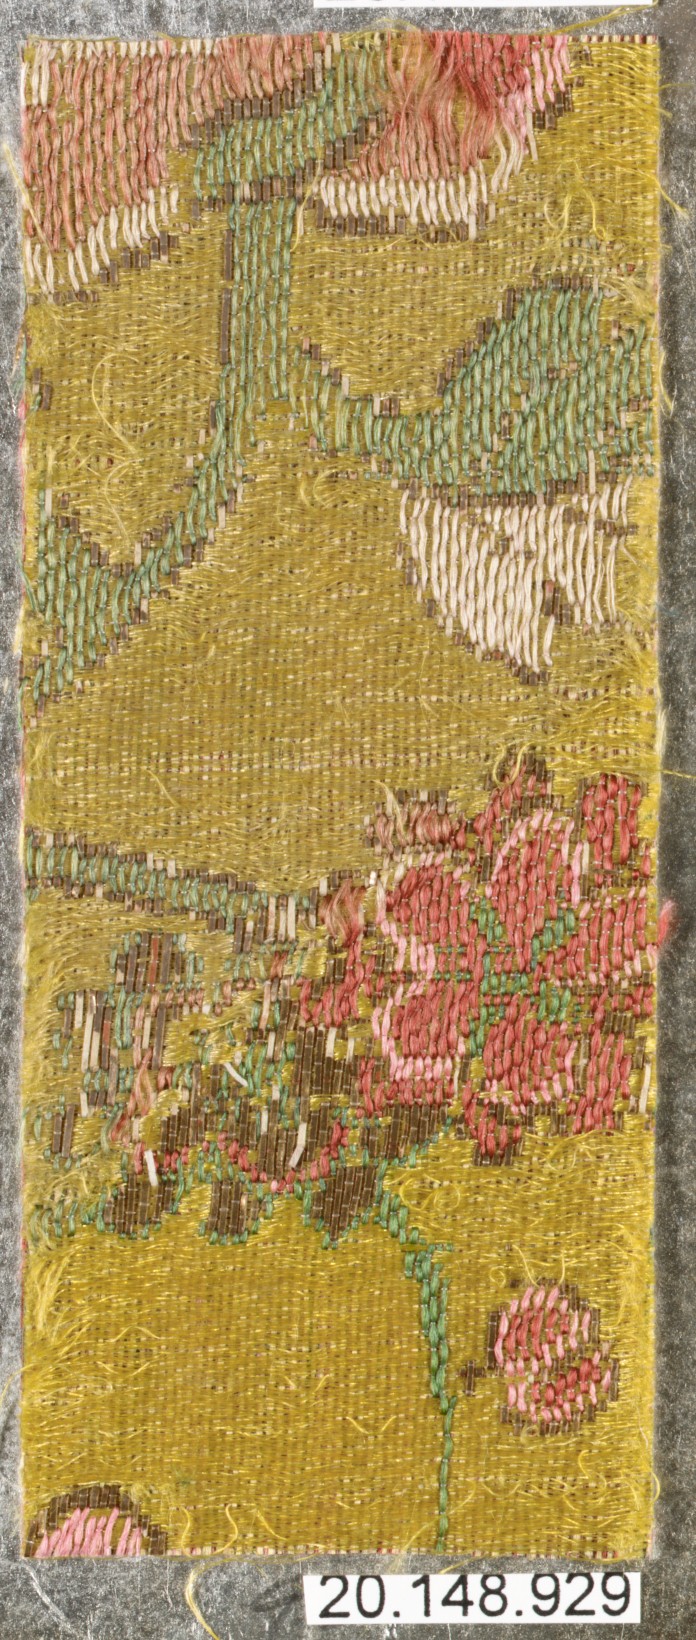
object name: piece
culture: japanese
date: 1701-1800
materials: silk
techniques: compound weave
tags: flowers